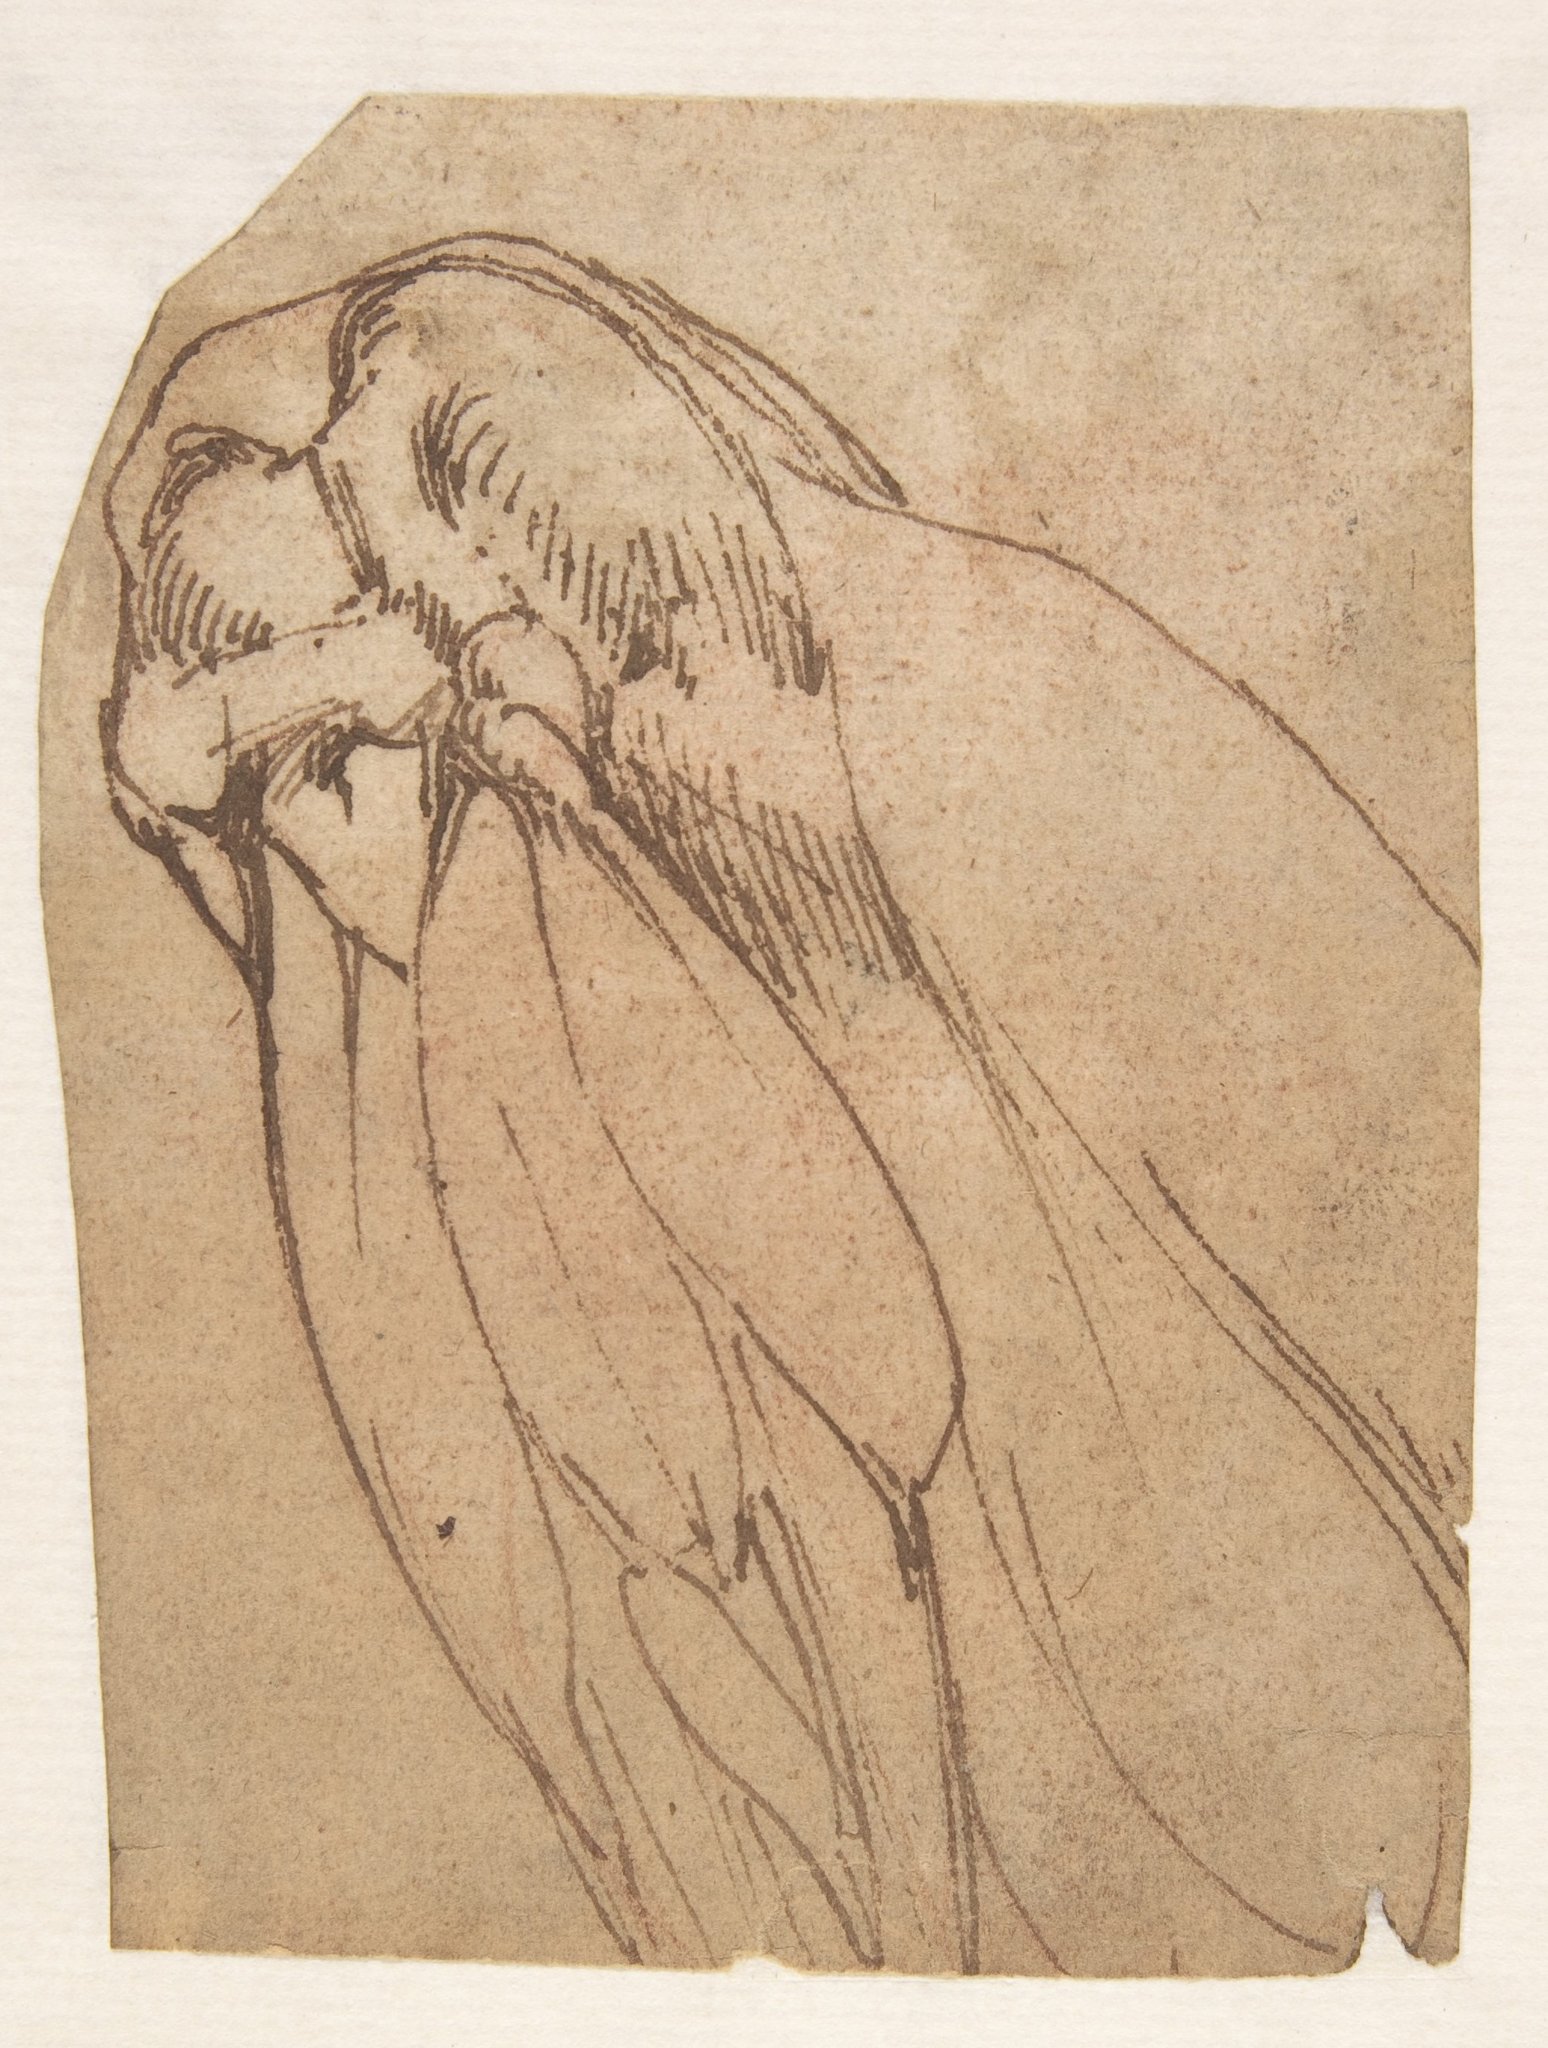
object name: drawing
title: Anatomical Study of a Knee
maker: michelangelo buonarroti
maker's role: artist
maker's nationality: italian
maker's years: 1475-1564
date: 1475-1564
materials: ink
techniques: pen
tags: legs